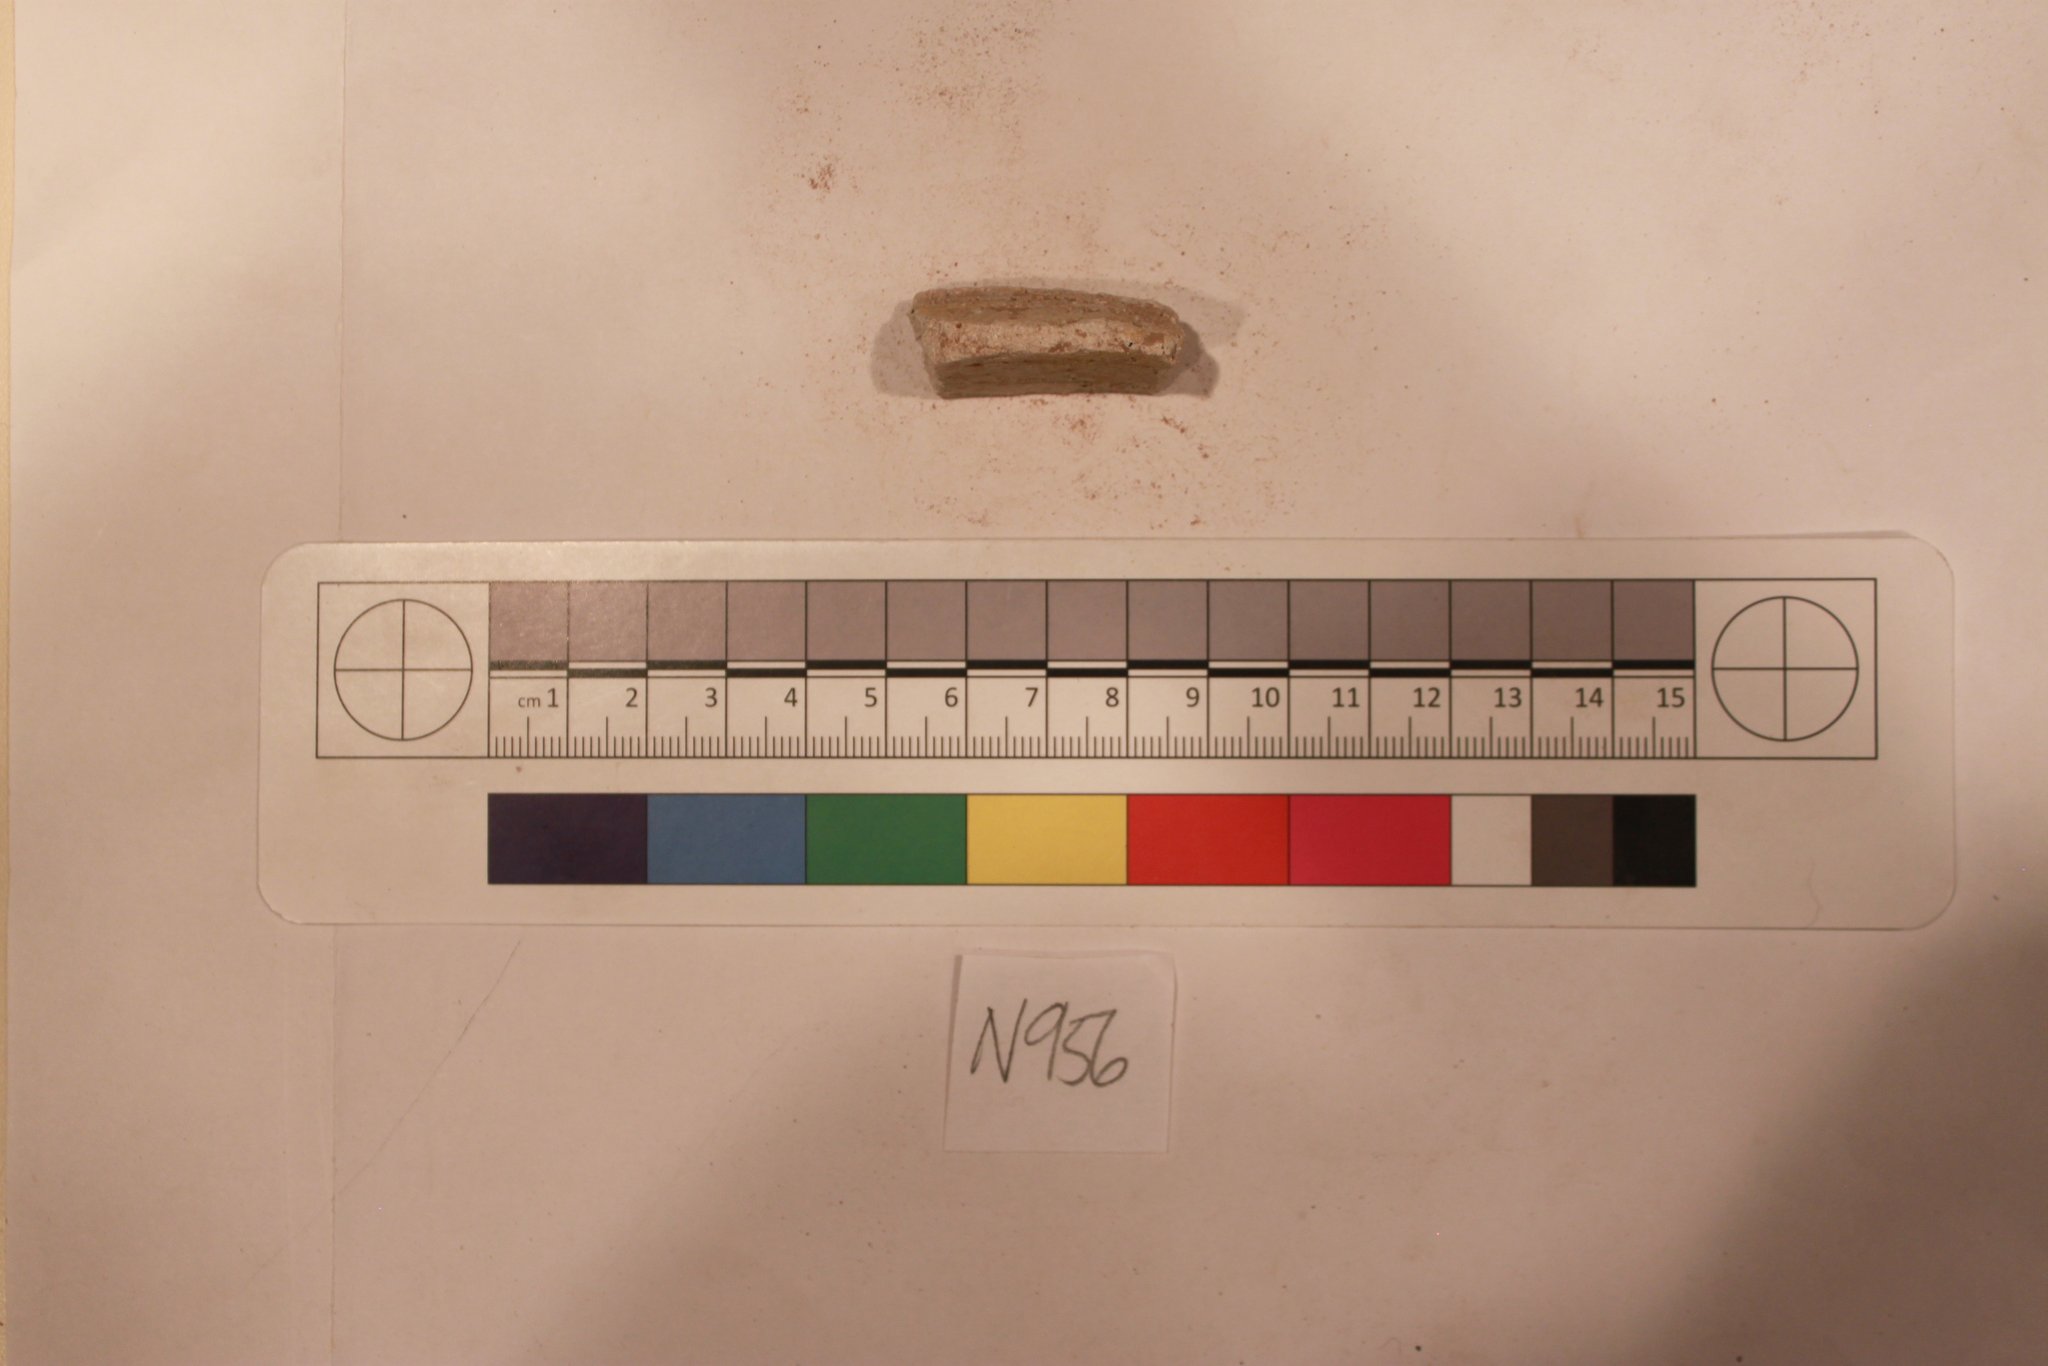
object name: fragment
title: Stucco Fragment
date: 701-1200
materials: plaster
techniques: carving, painting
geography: iran